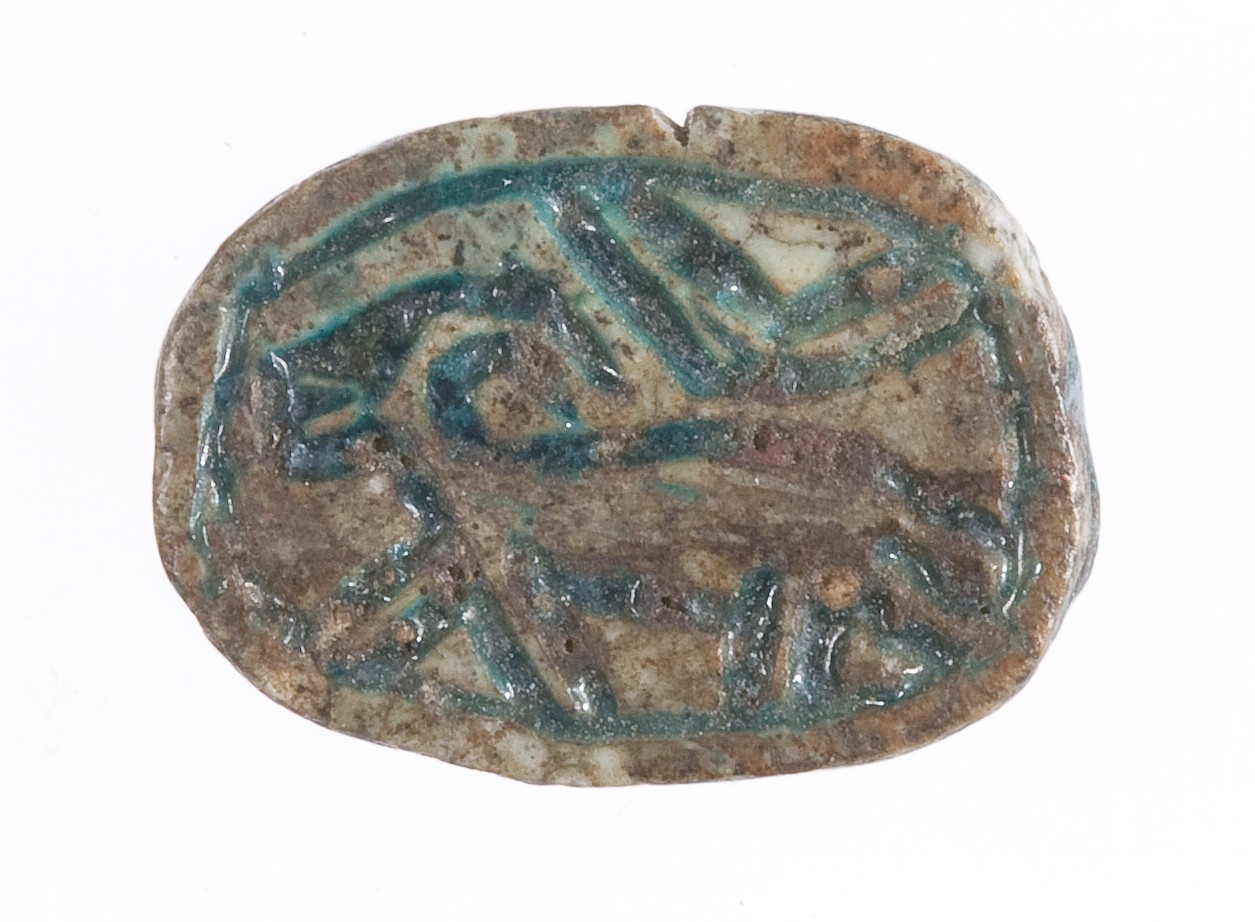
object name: scarab, antelope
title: Scarab with device of an antelope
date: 1550-1500 BCE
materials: stone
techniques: glazing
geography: egypt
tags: animals,scarabs